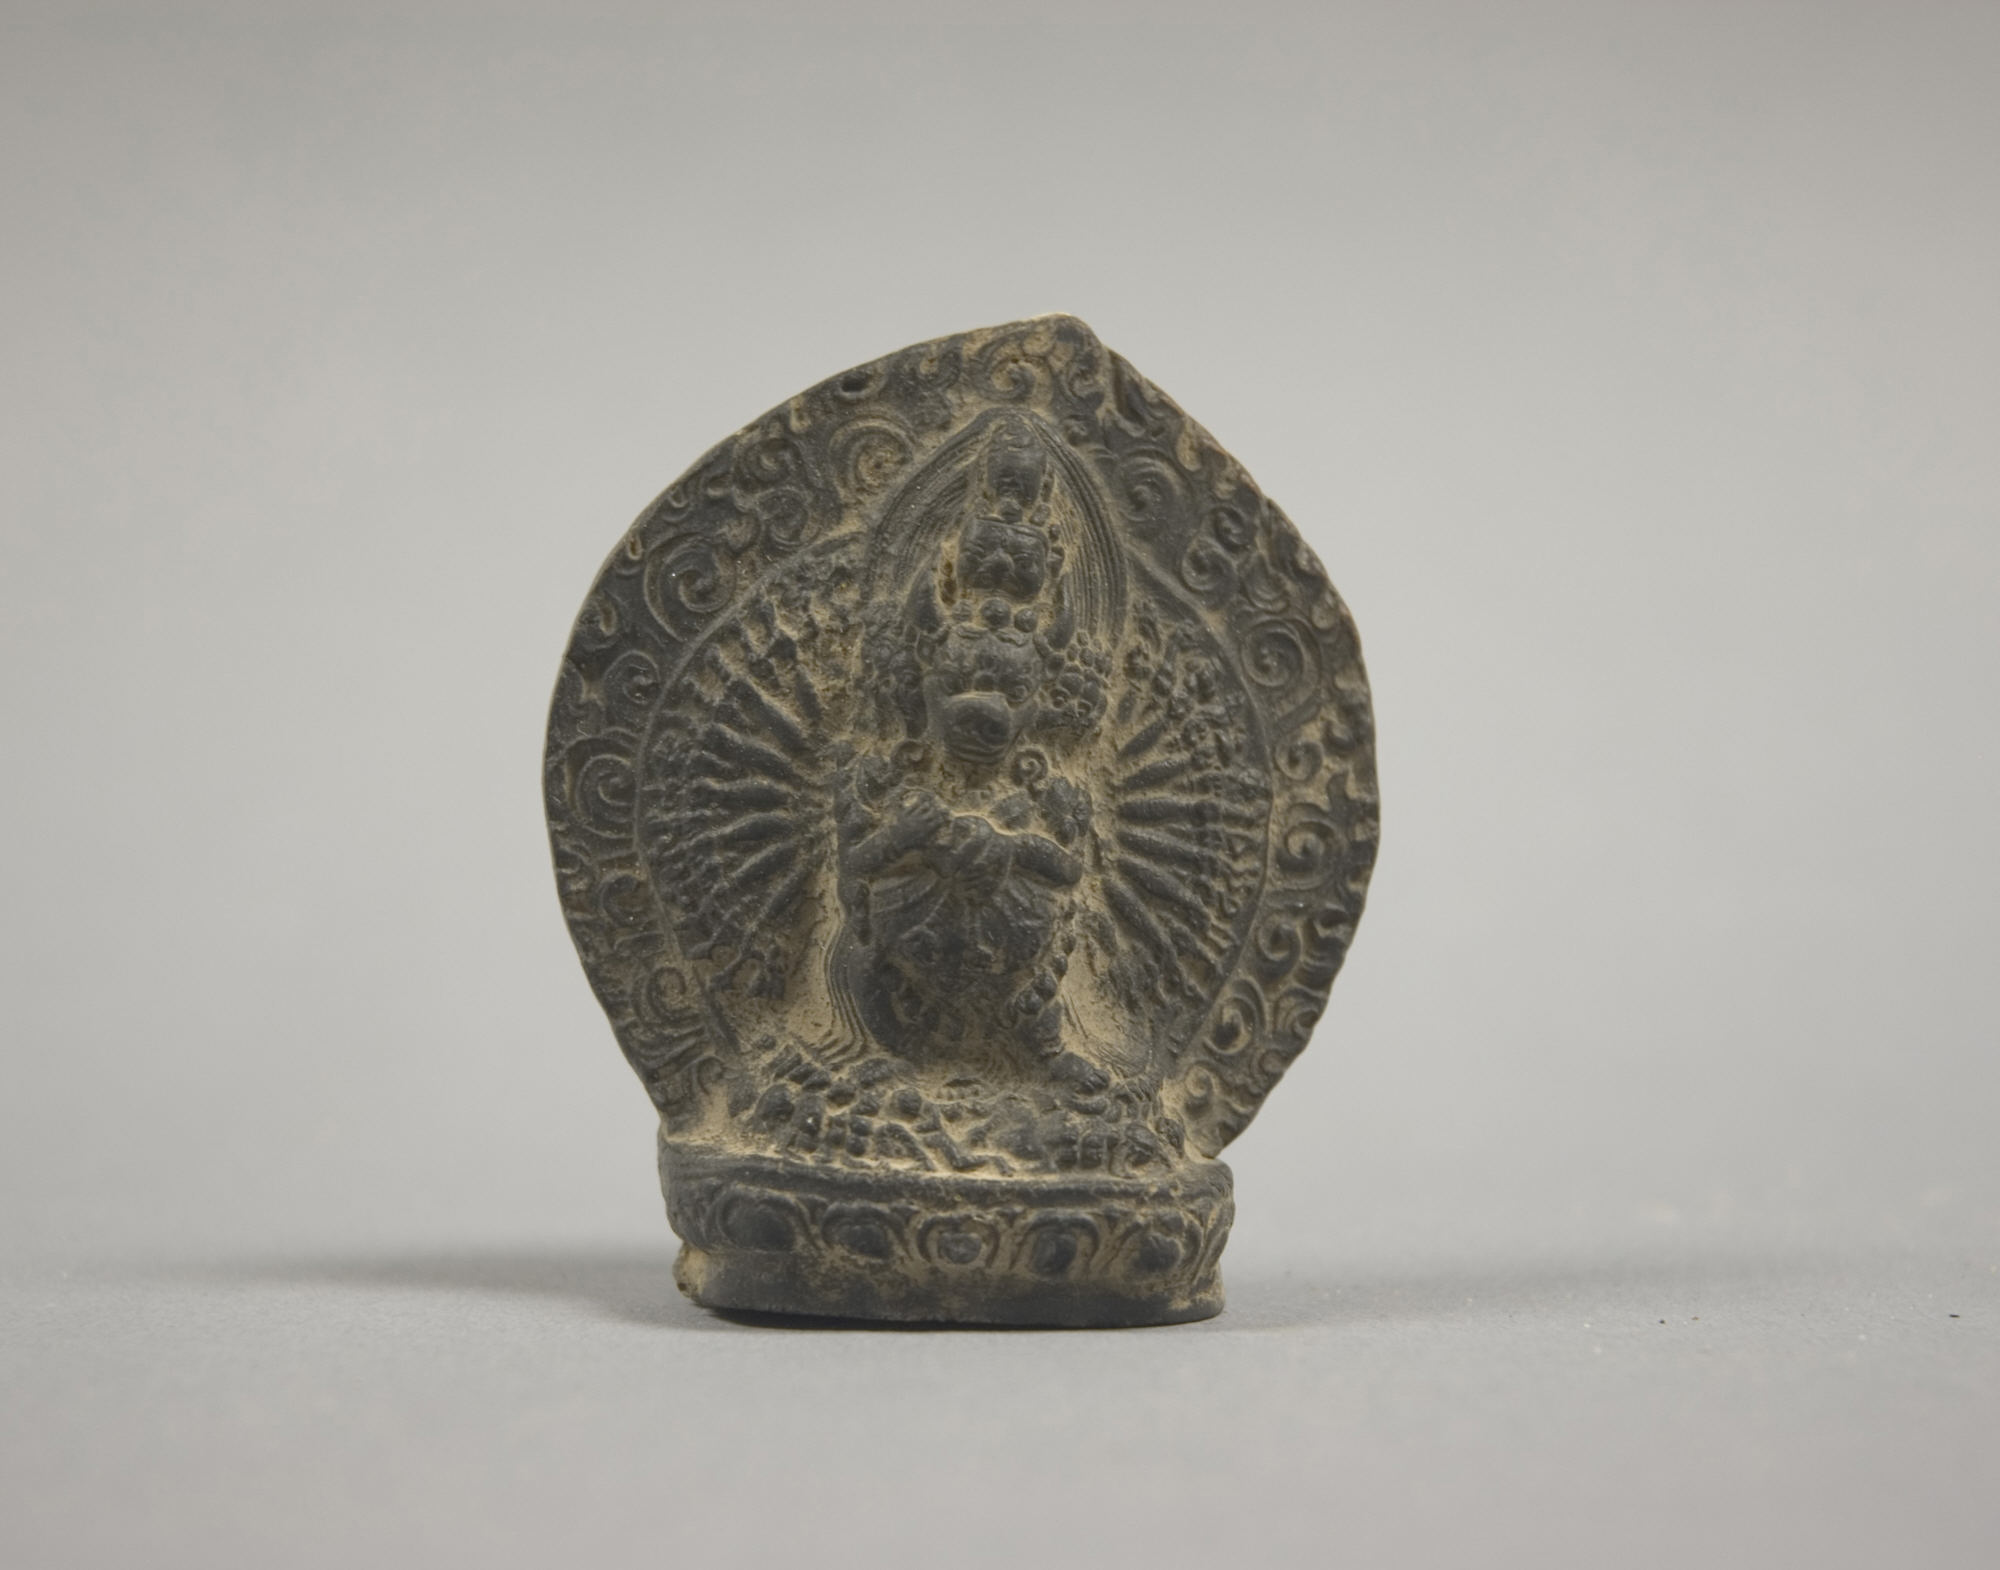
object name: votive plaque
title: Votive Plaque with Yamantaka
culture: tibetan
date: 701-800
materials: clay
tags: buddhism,deities